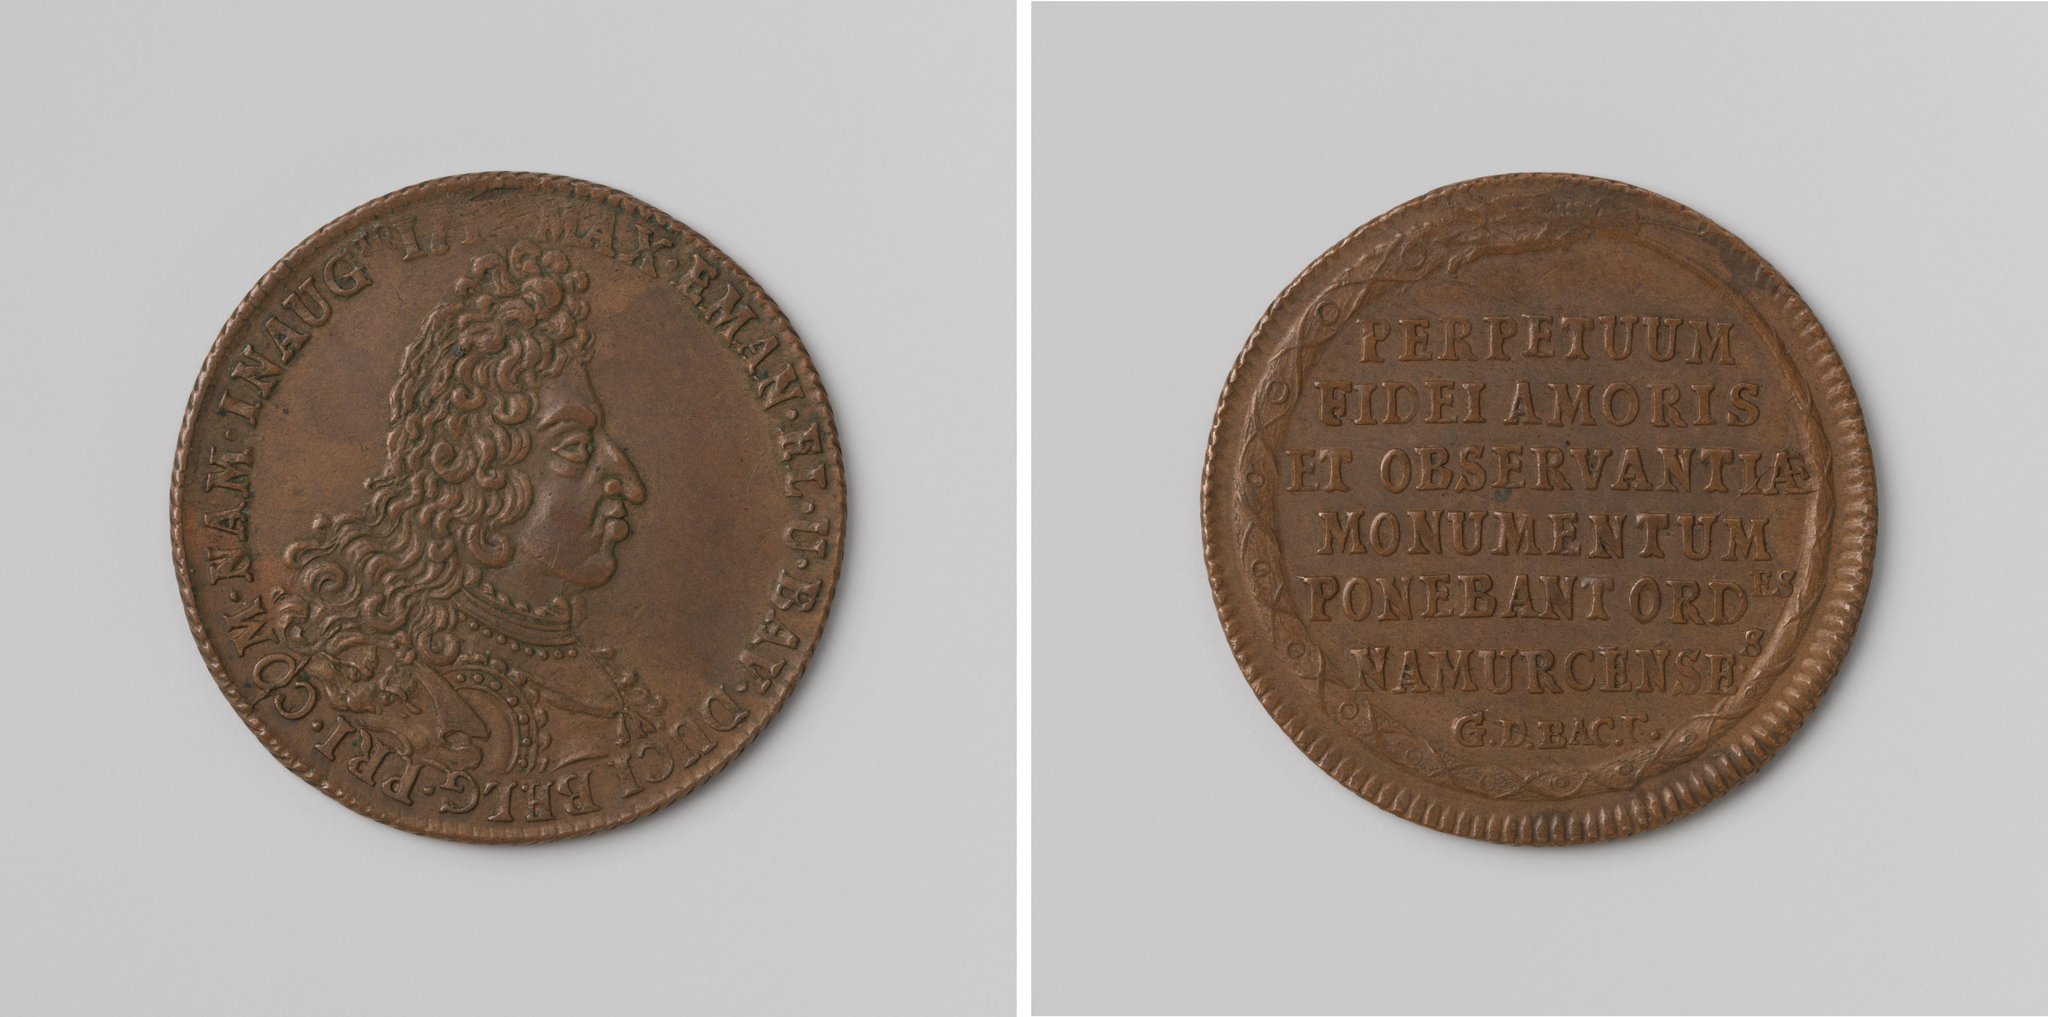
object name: jeton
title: Maximiliaan II Emanuel, keurvorst van Beieren, ingehuldigd als graaf van Namen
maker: g. de backer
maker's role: medailleur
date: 1712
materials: copper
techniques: striking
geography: namur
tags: maximiliaan ii emanuel (keurvorst van beieren), namur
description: Koperen penning. Voorzijde: borststuk man binnen omschrift. Keerzijde: opschrift binnen slangerond